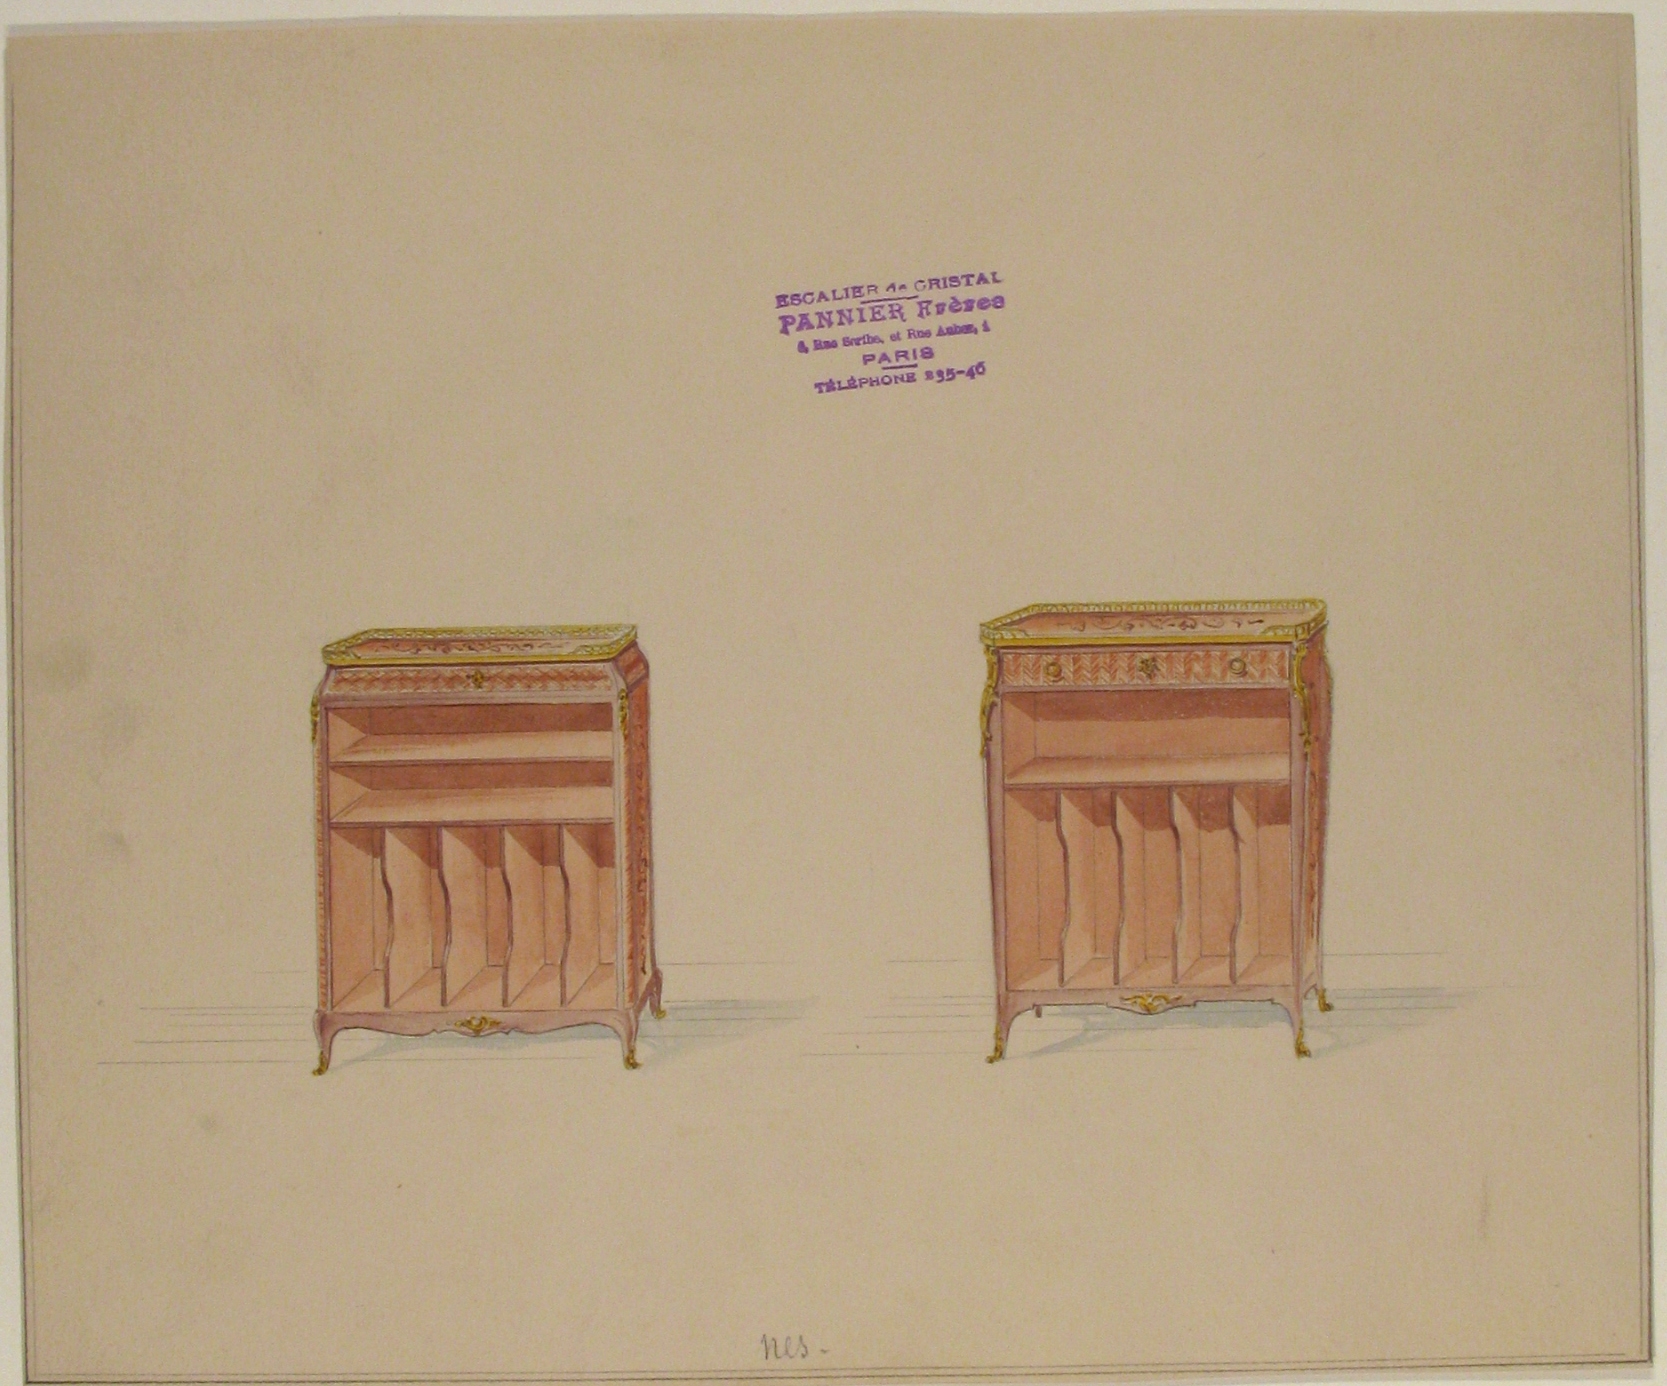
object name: drawing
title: Two Designs for Tables with Shelves and Dividers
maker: anonymous, french, 19th century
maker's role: artist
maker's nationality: french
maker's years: 1800-1900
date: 1900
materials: graphite, watercolor, paper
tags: tables